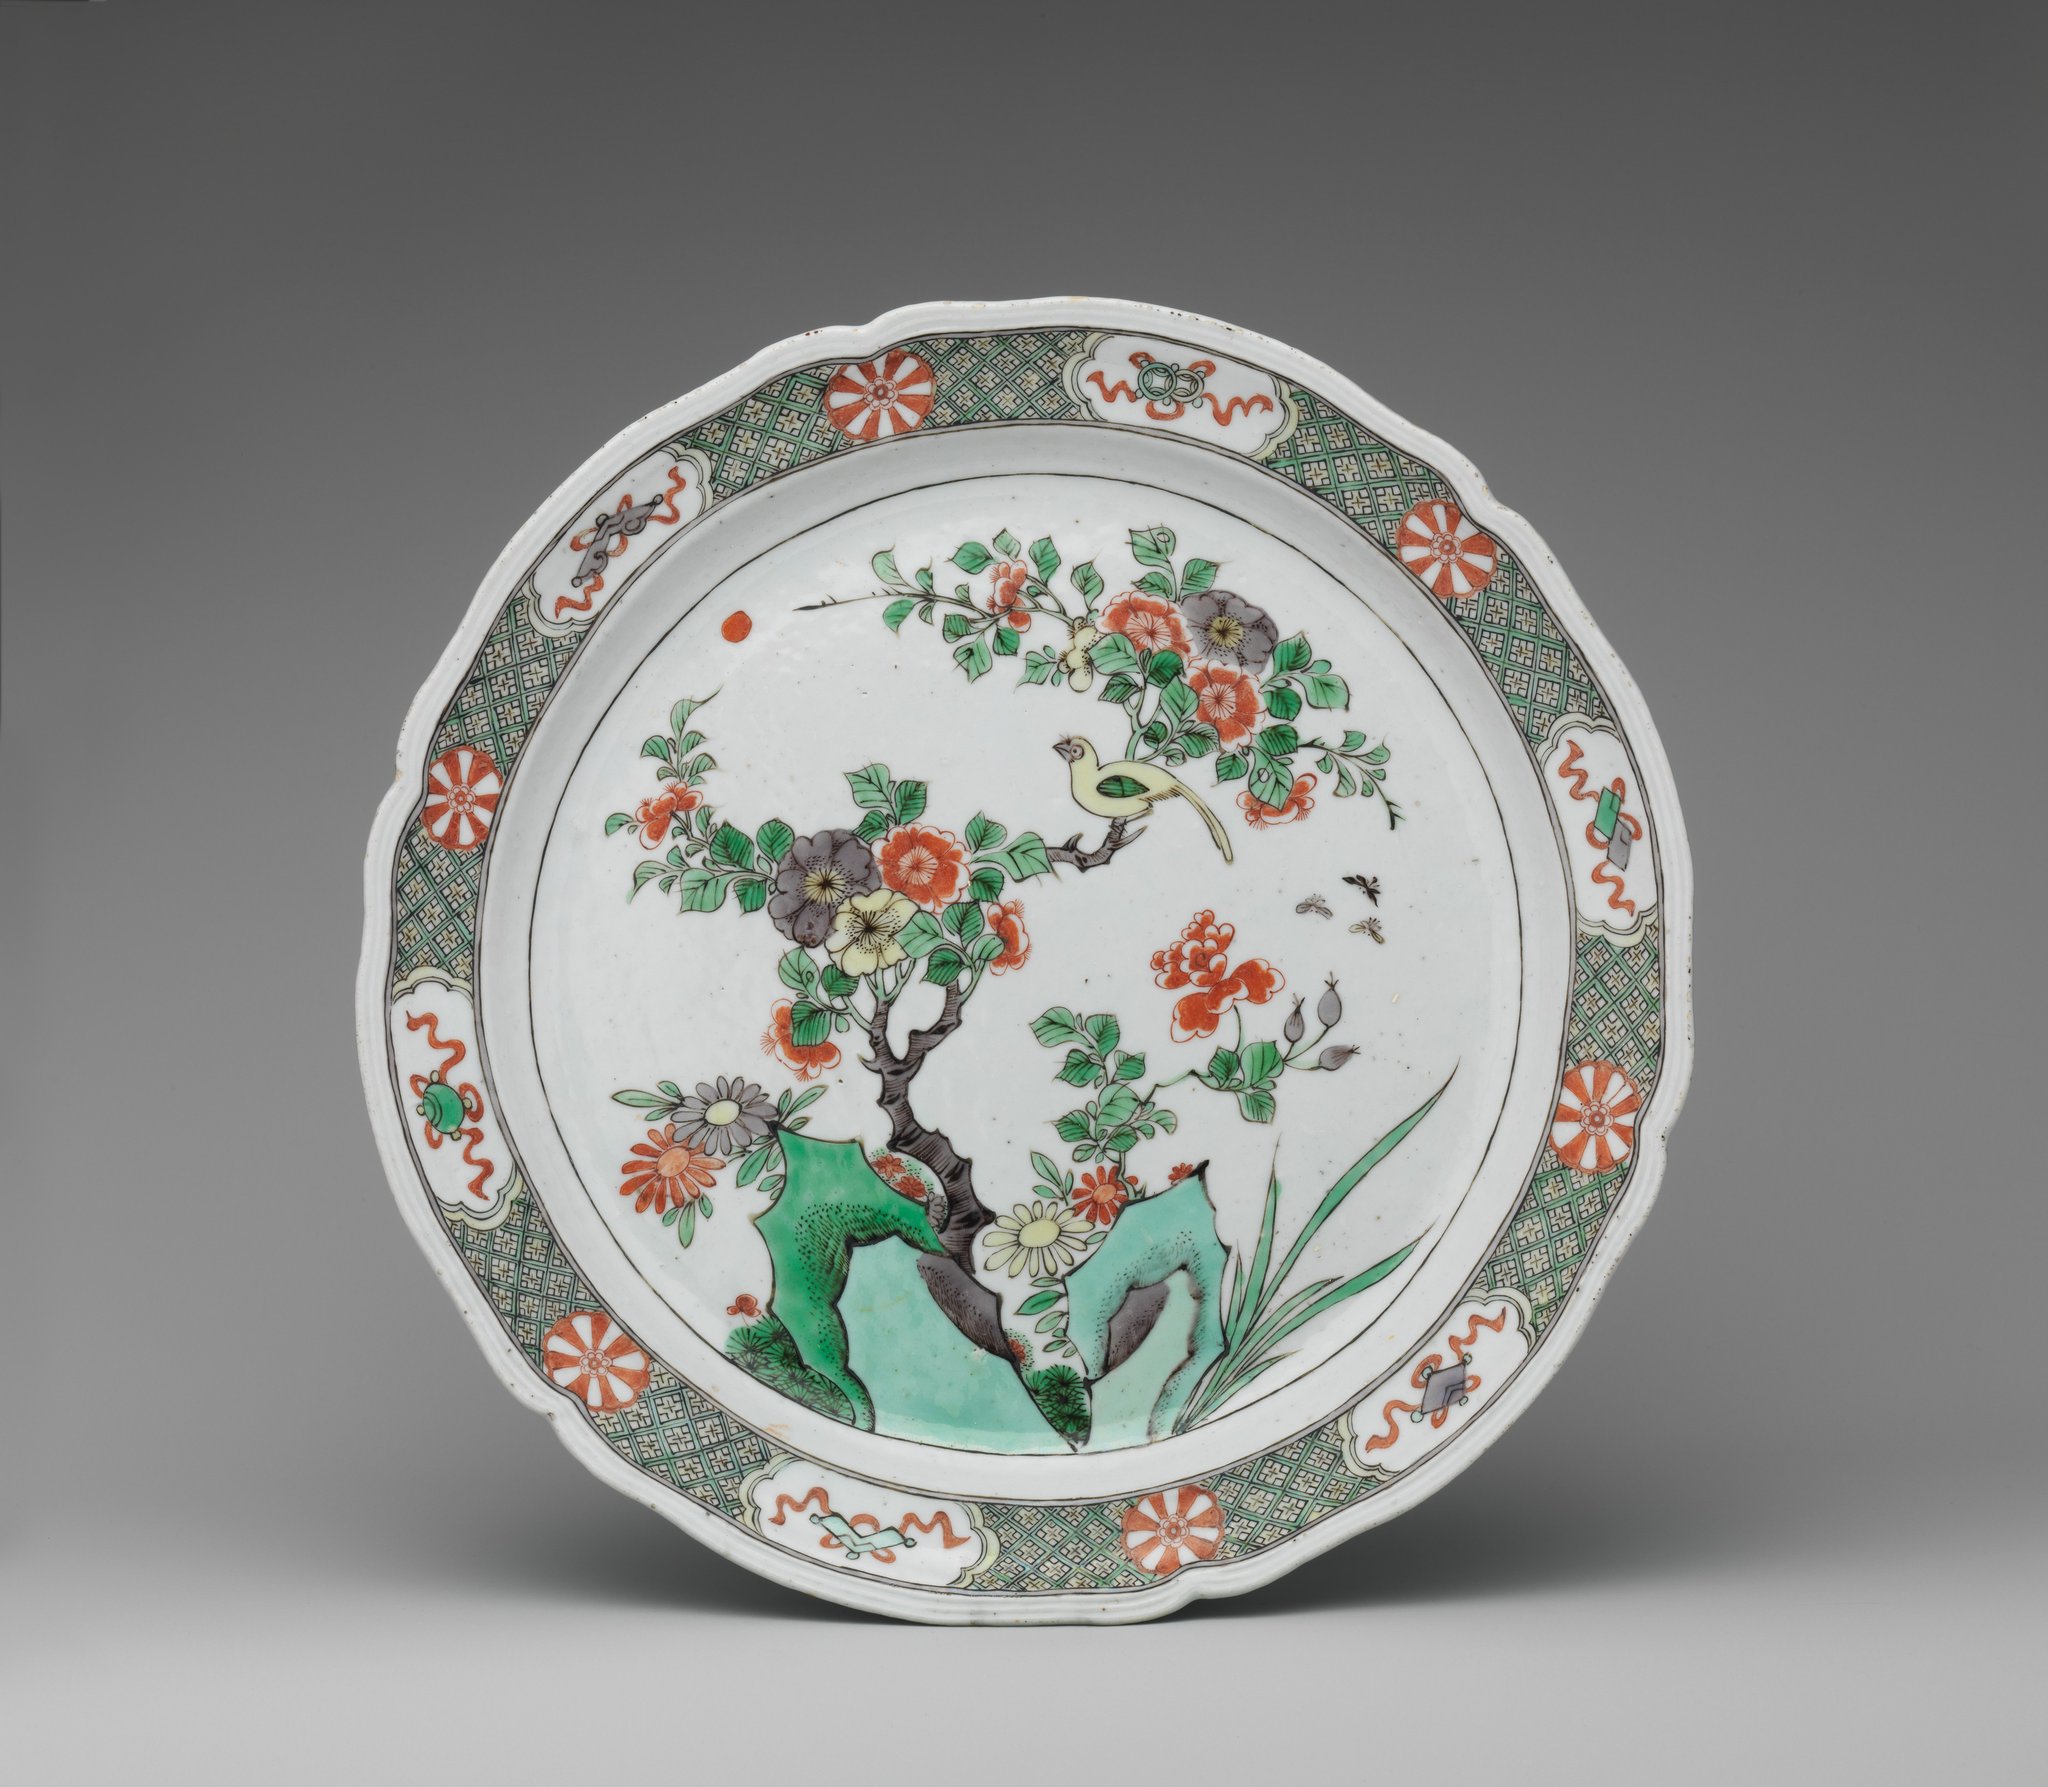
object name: dish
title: Dish with rocks, flowers, and birds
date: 1725-1730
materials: enamel, glaze, hard paste porcelain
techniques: painting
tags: birds,flowers,trees